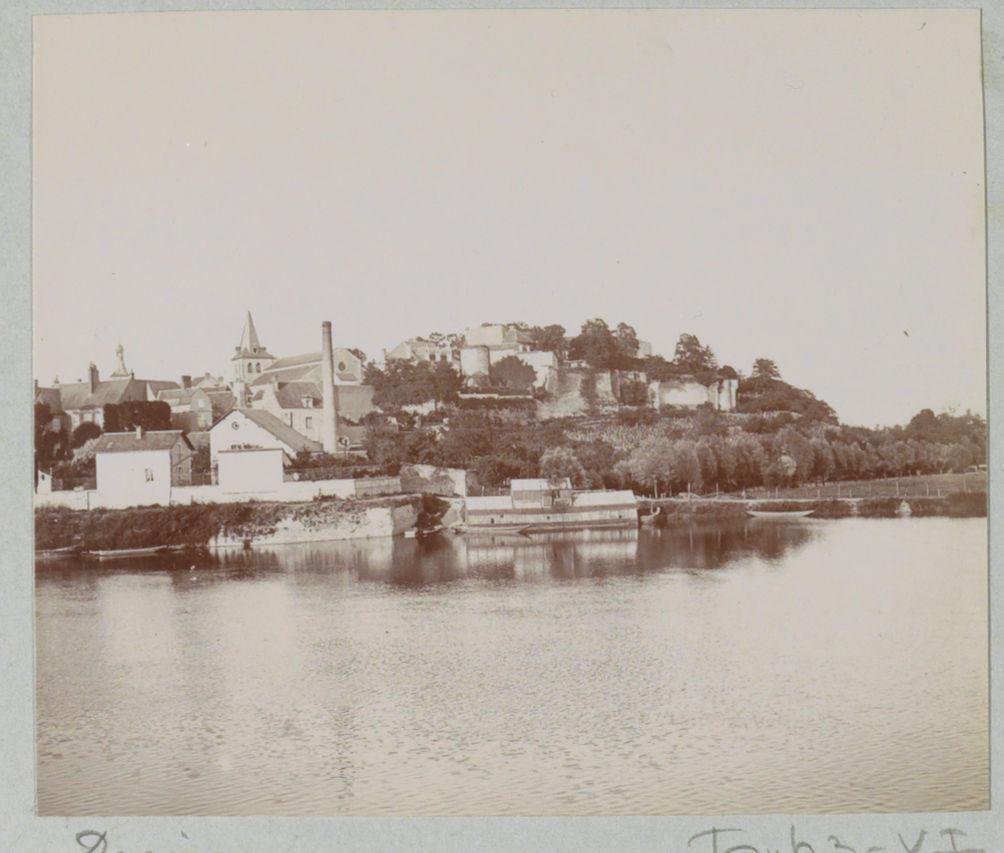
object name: photograph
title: Gezicht op Decize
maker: delizy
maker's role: manufacturer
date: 1904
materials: paper, photographic support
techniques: gelatin silver print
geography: decize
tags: prospect of village, silhouette of village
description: Onderdeel van Fotoalbum van een Franse amateurfotograaf met opnames van uitstapjes in Frankrijk, Spanje, België, Luxemburg en Nederland, de eerste automobielen en autoraces.